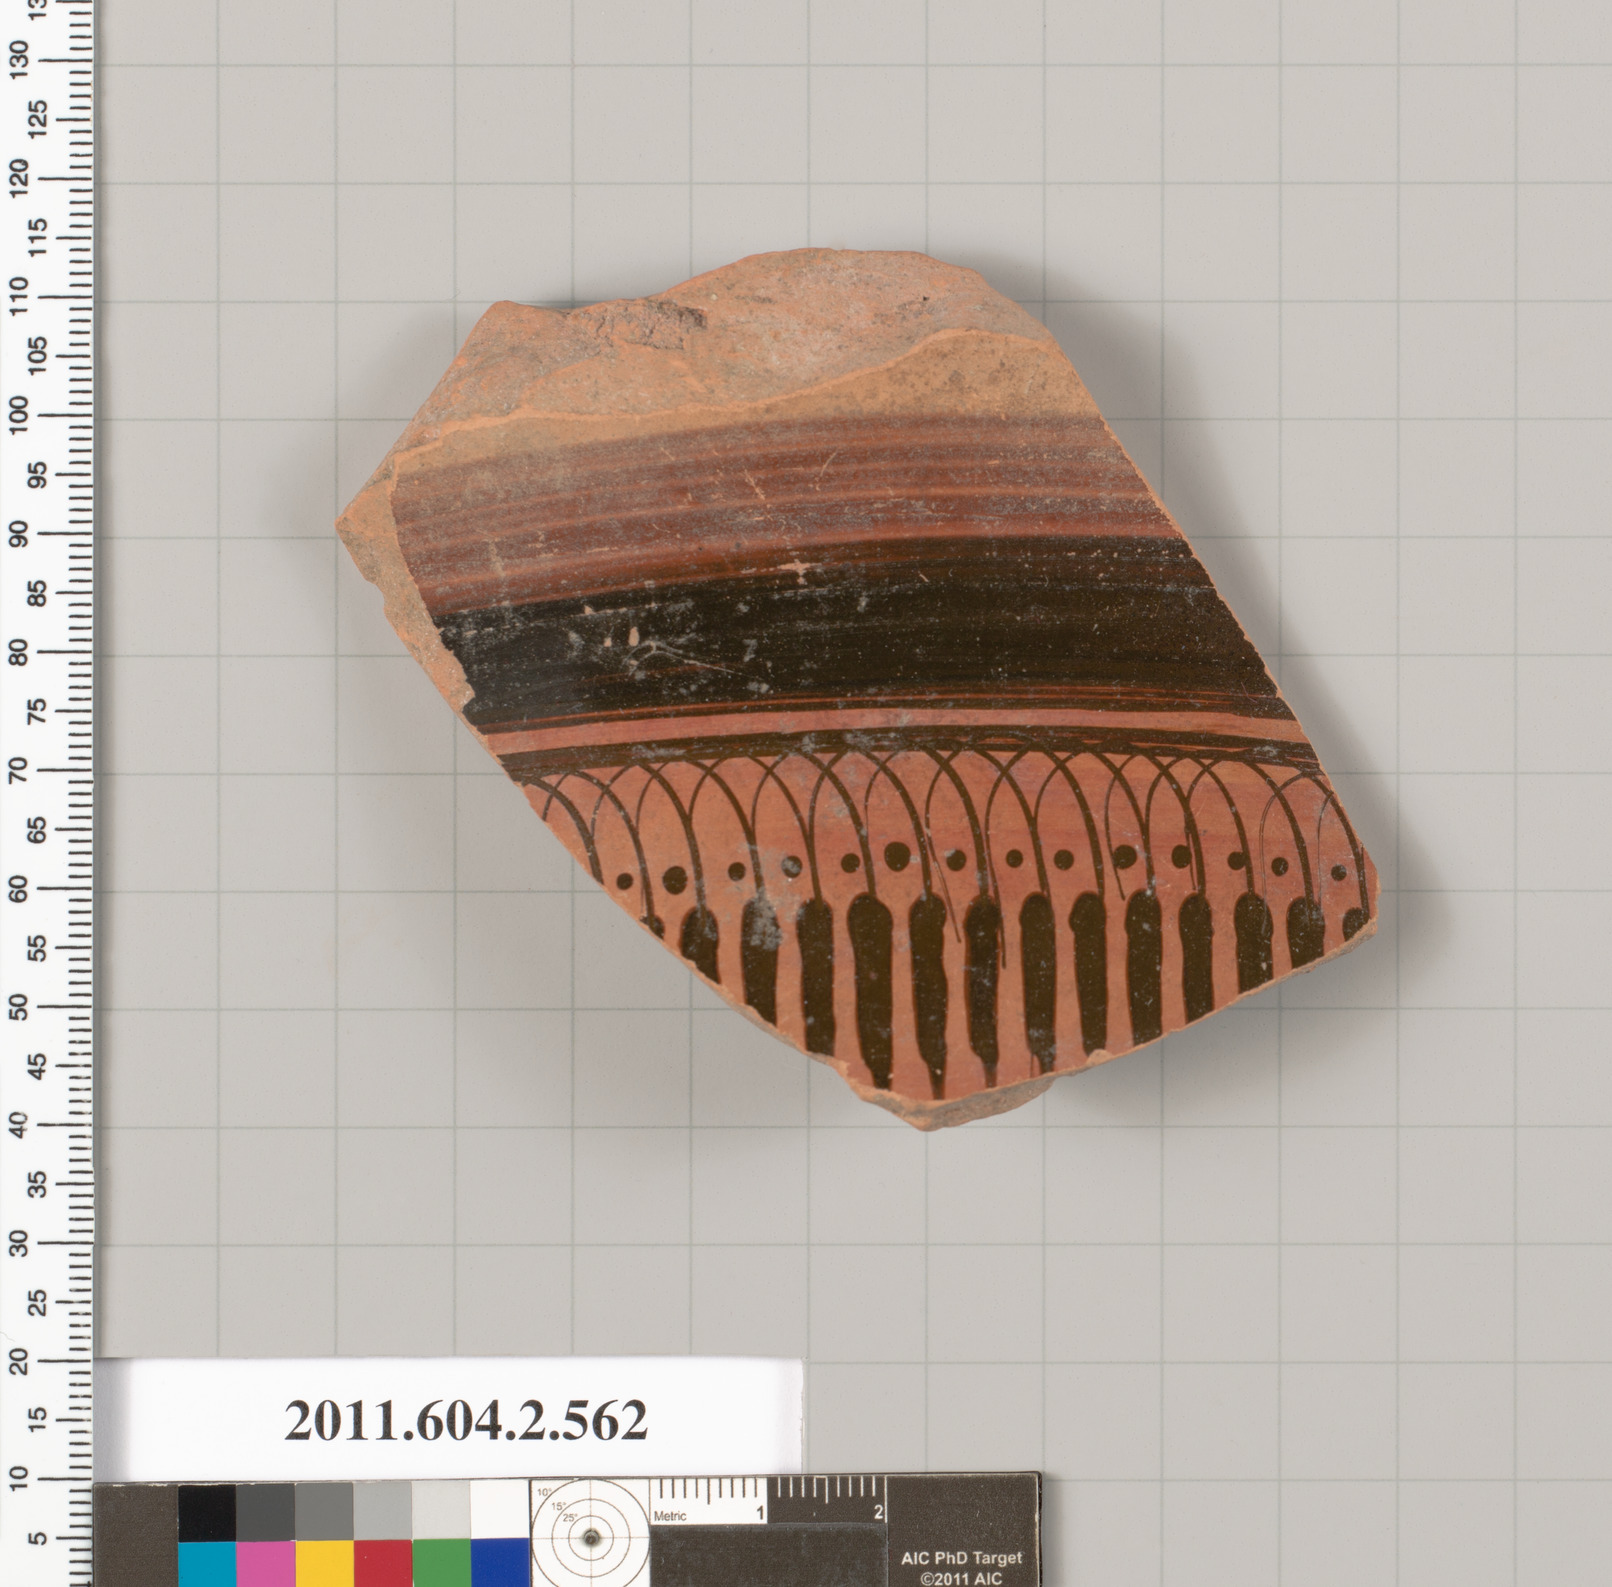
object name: column krater fragment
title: Terracotta fragment of a column-krater (bowl for mixing wine and water)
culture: greek, attic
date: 467-435 BCE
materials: terracotta